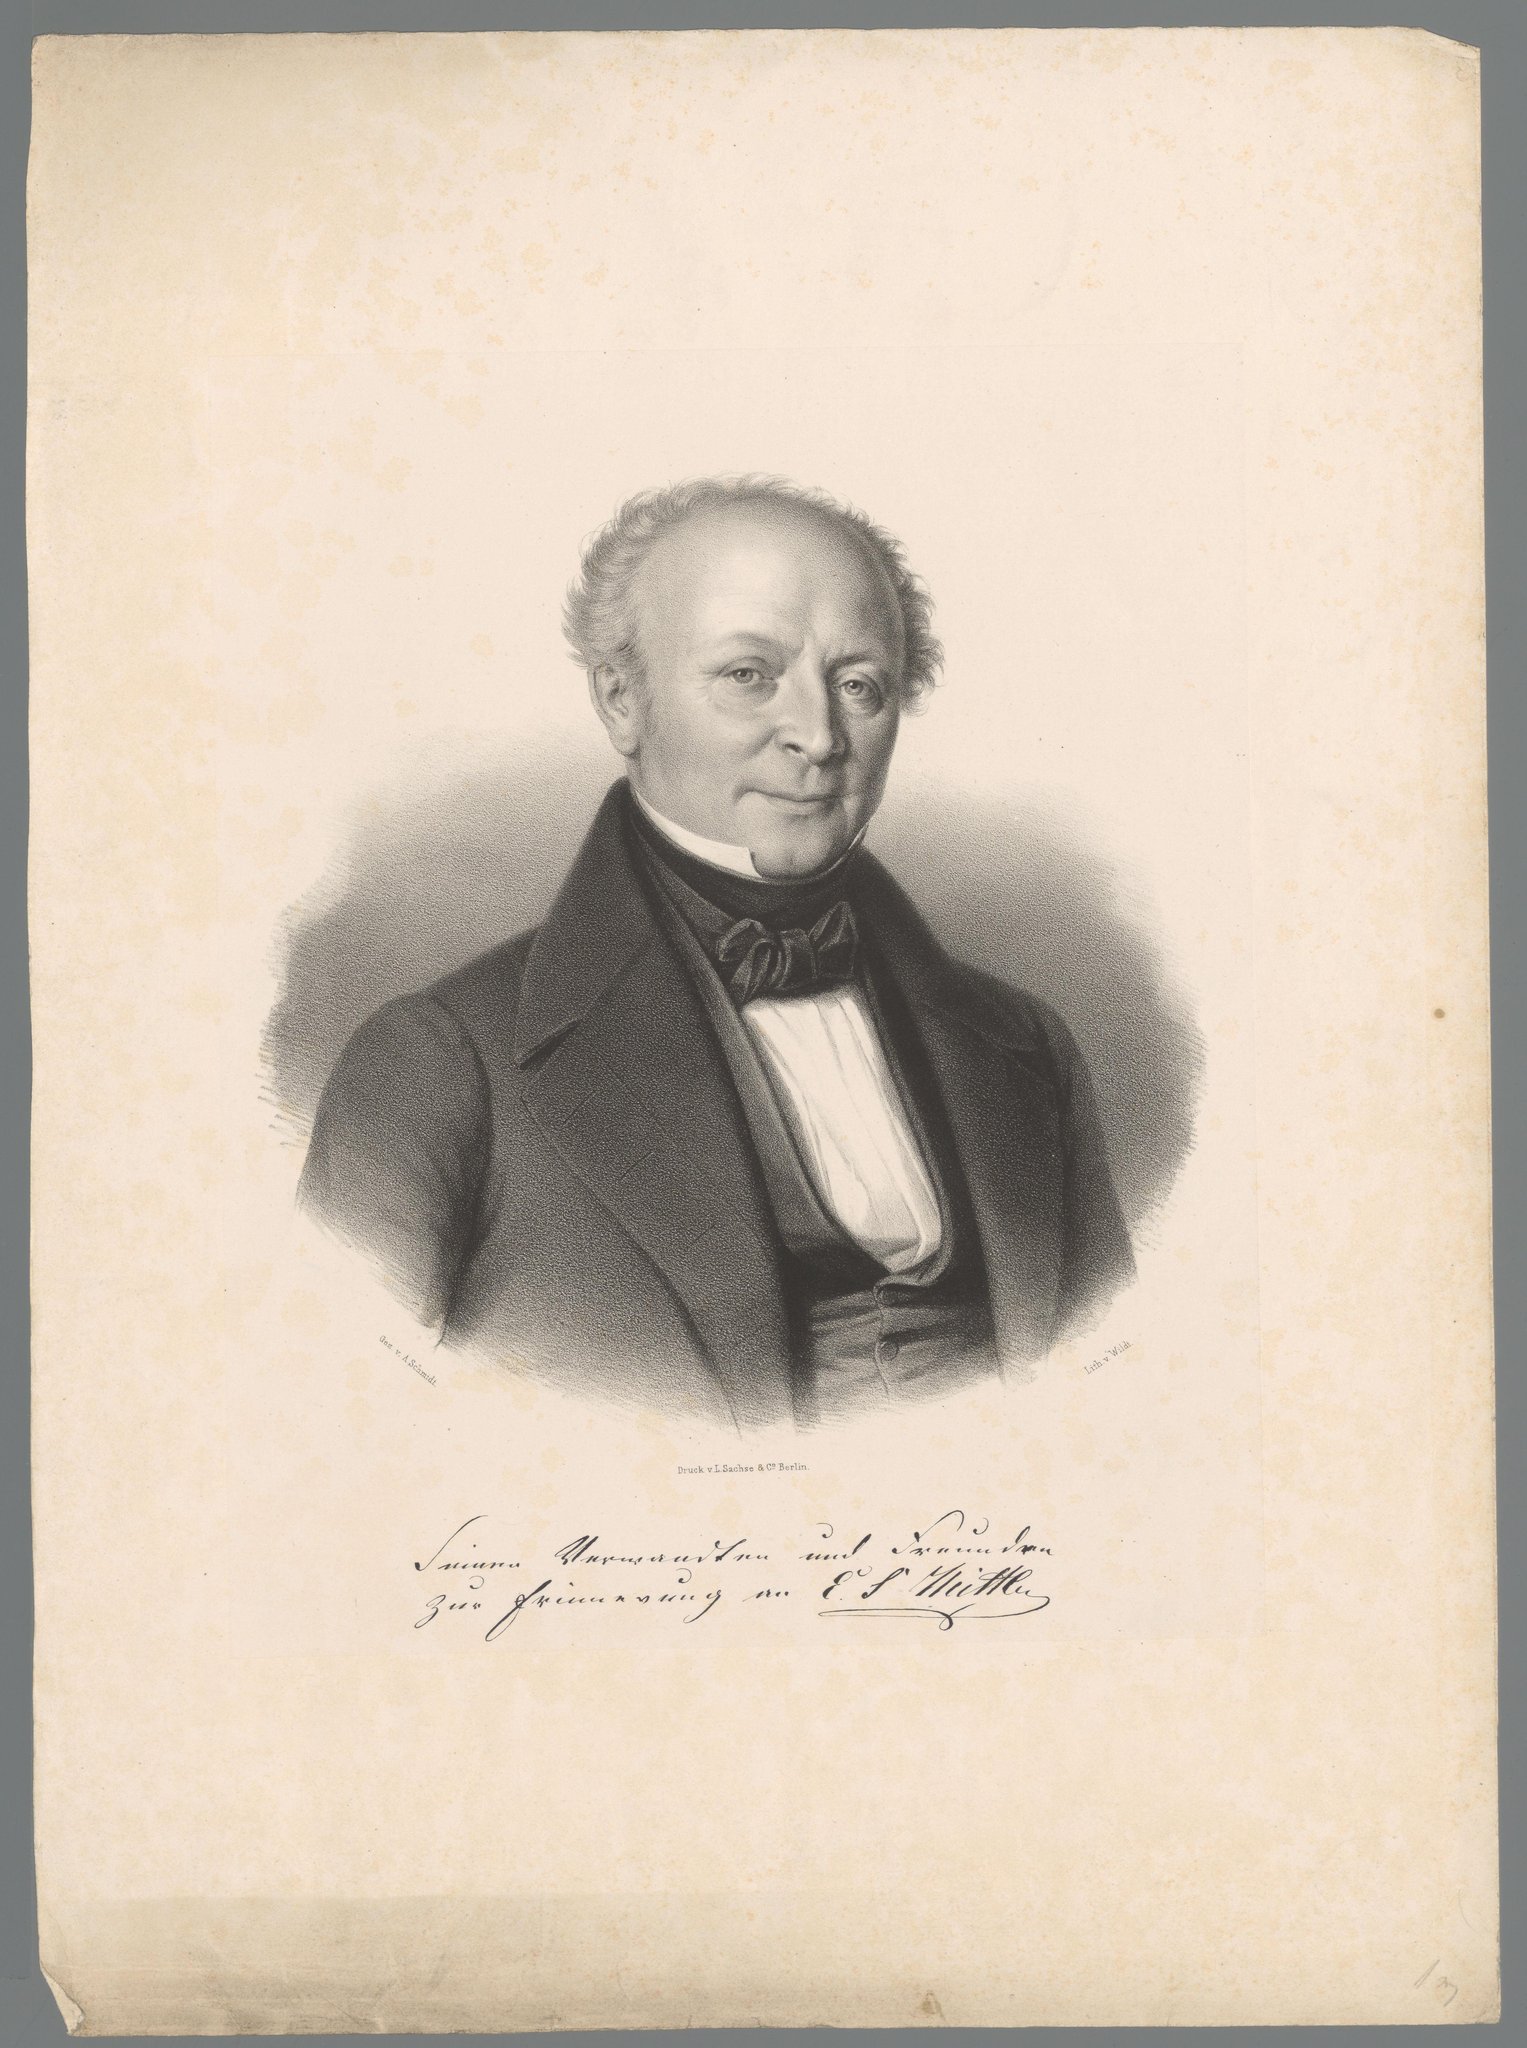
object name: print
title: Portret van Ernst Siegfried Mittler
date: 1832-1854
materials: paper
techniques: lithograph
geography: berlin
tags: publisher, historical persons, publishing, publisher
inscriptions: collector's mark: Lugt 2228